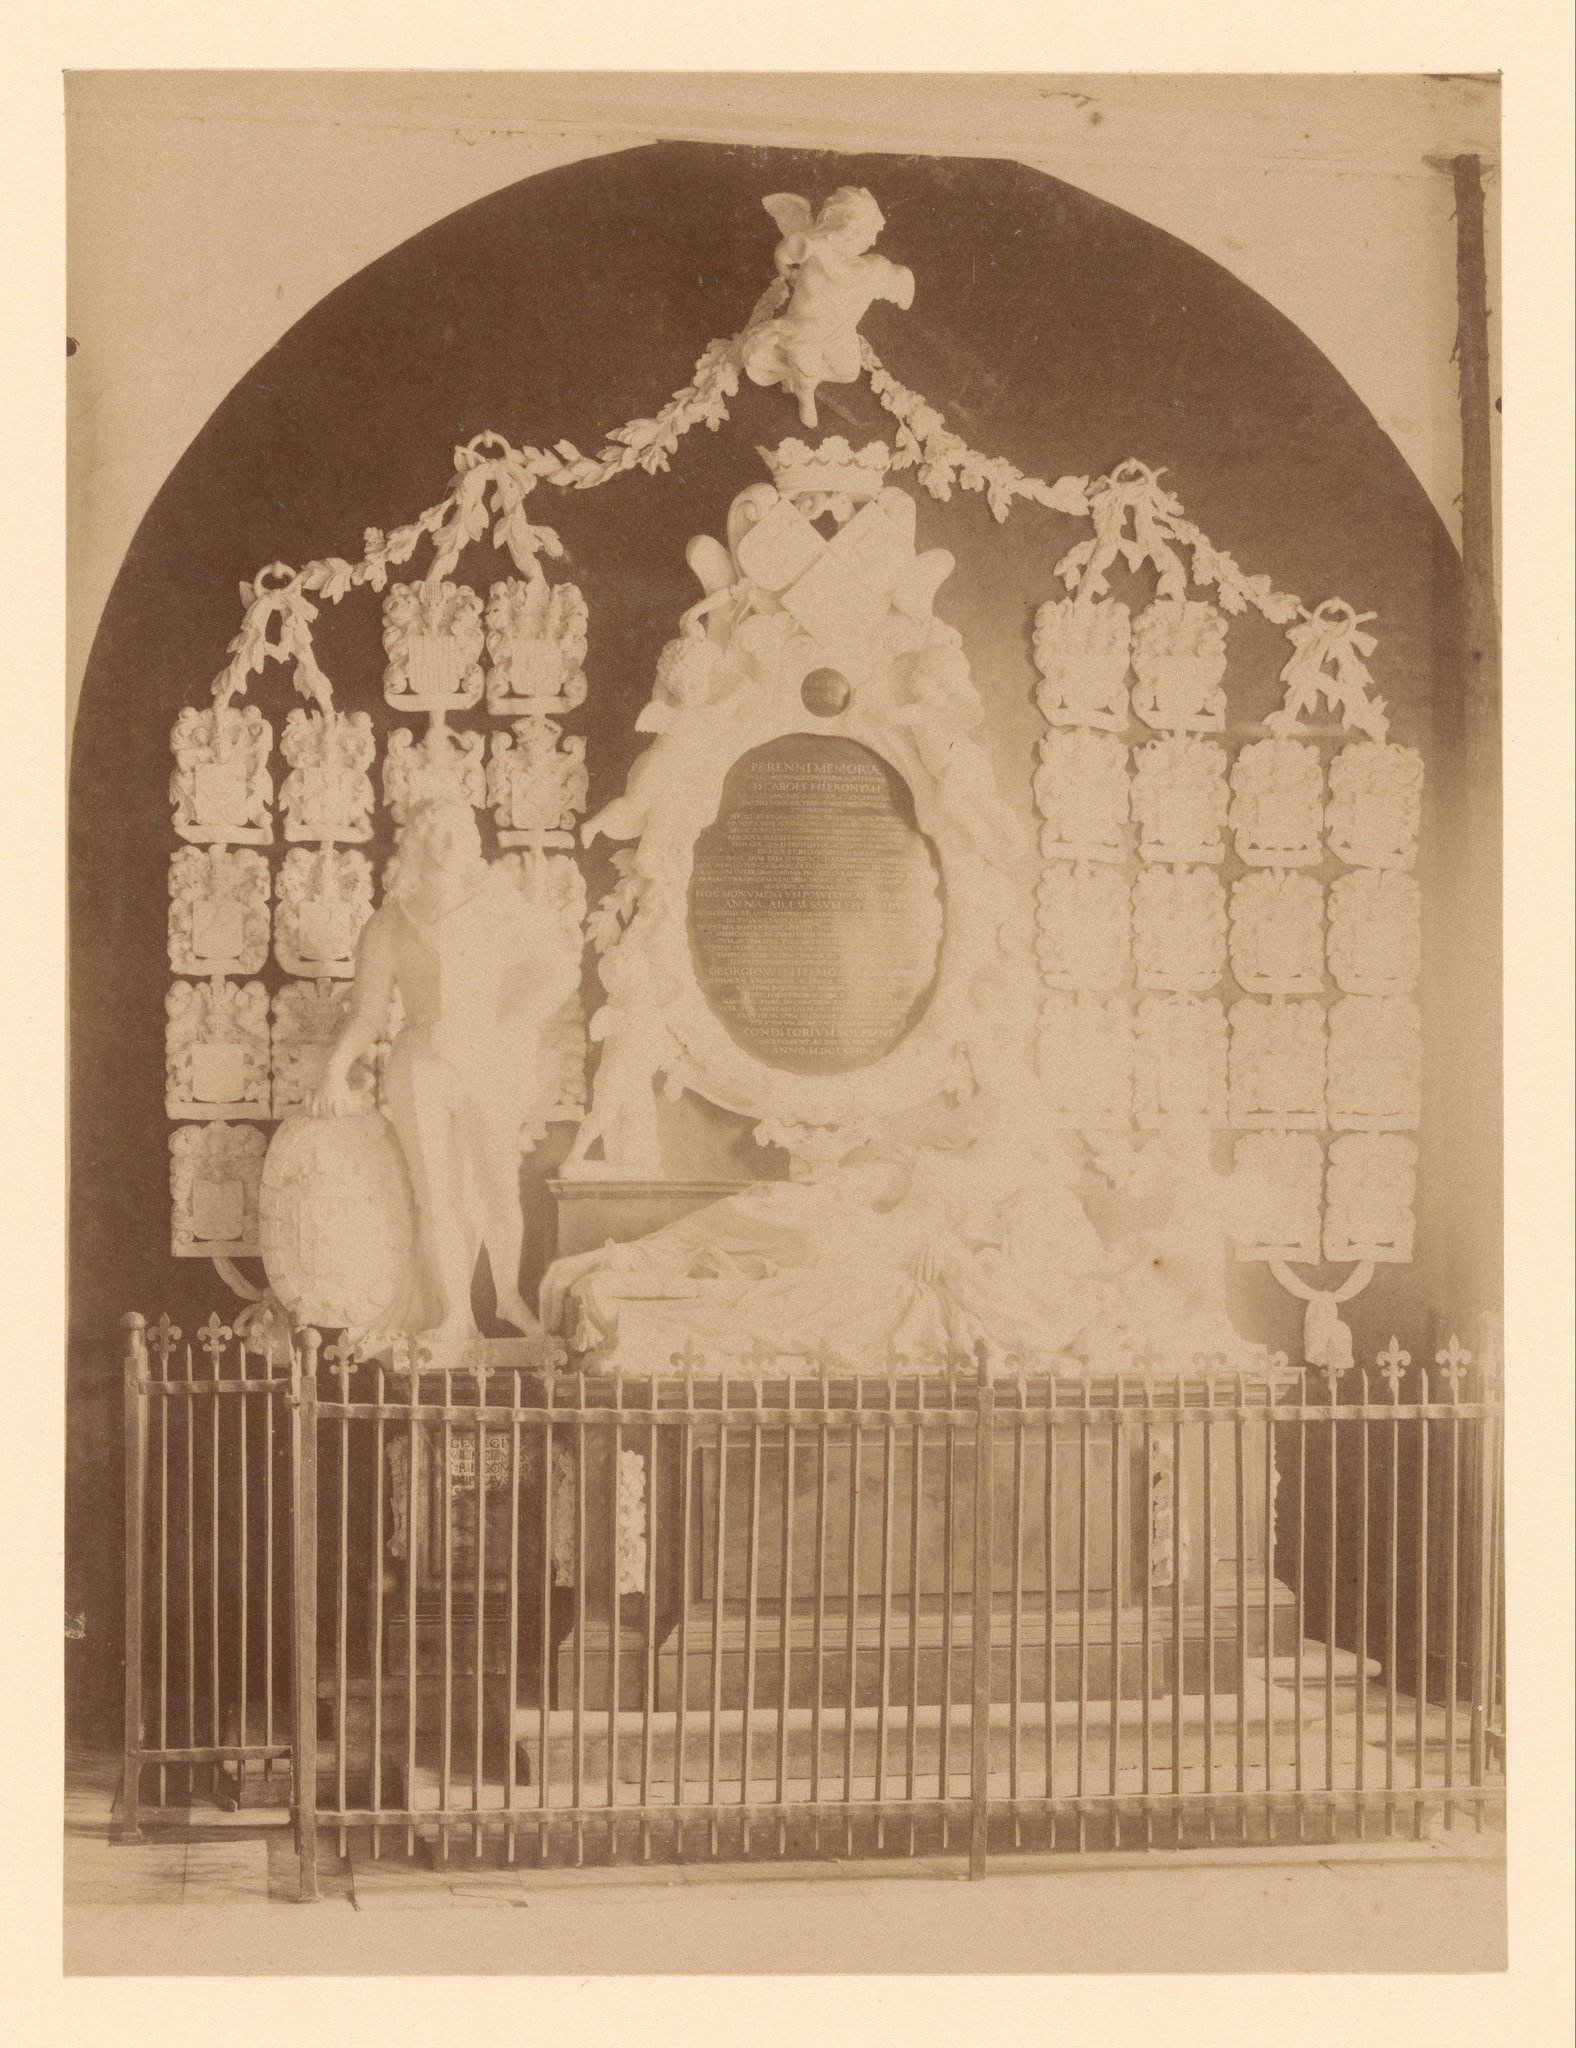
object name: photograph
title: Grafmonument van Carel Hieronymus van Inn- en Kniphuisen en Anna van Ewsum in de kerk van Midwolde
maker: anoniem (monumentenzorg)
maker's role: fotograaf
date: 1897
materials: cardboard, photographic support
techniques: albumen print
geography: midwolde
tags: interior of church, grave-building, monumental tomb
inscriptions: annotation: ‘Grafmonument door Robout Verhulst (1669) in de Kerk te Midwolde/ april 1897’, annotation: ‘Midwolde’